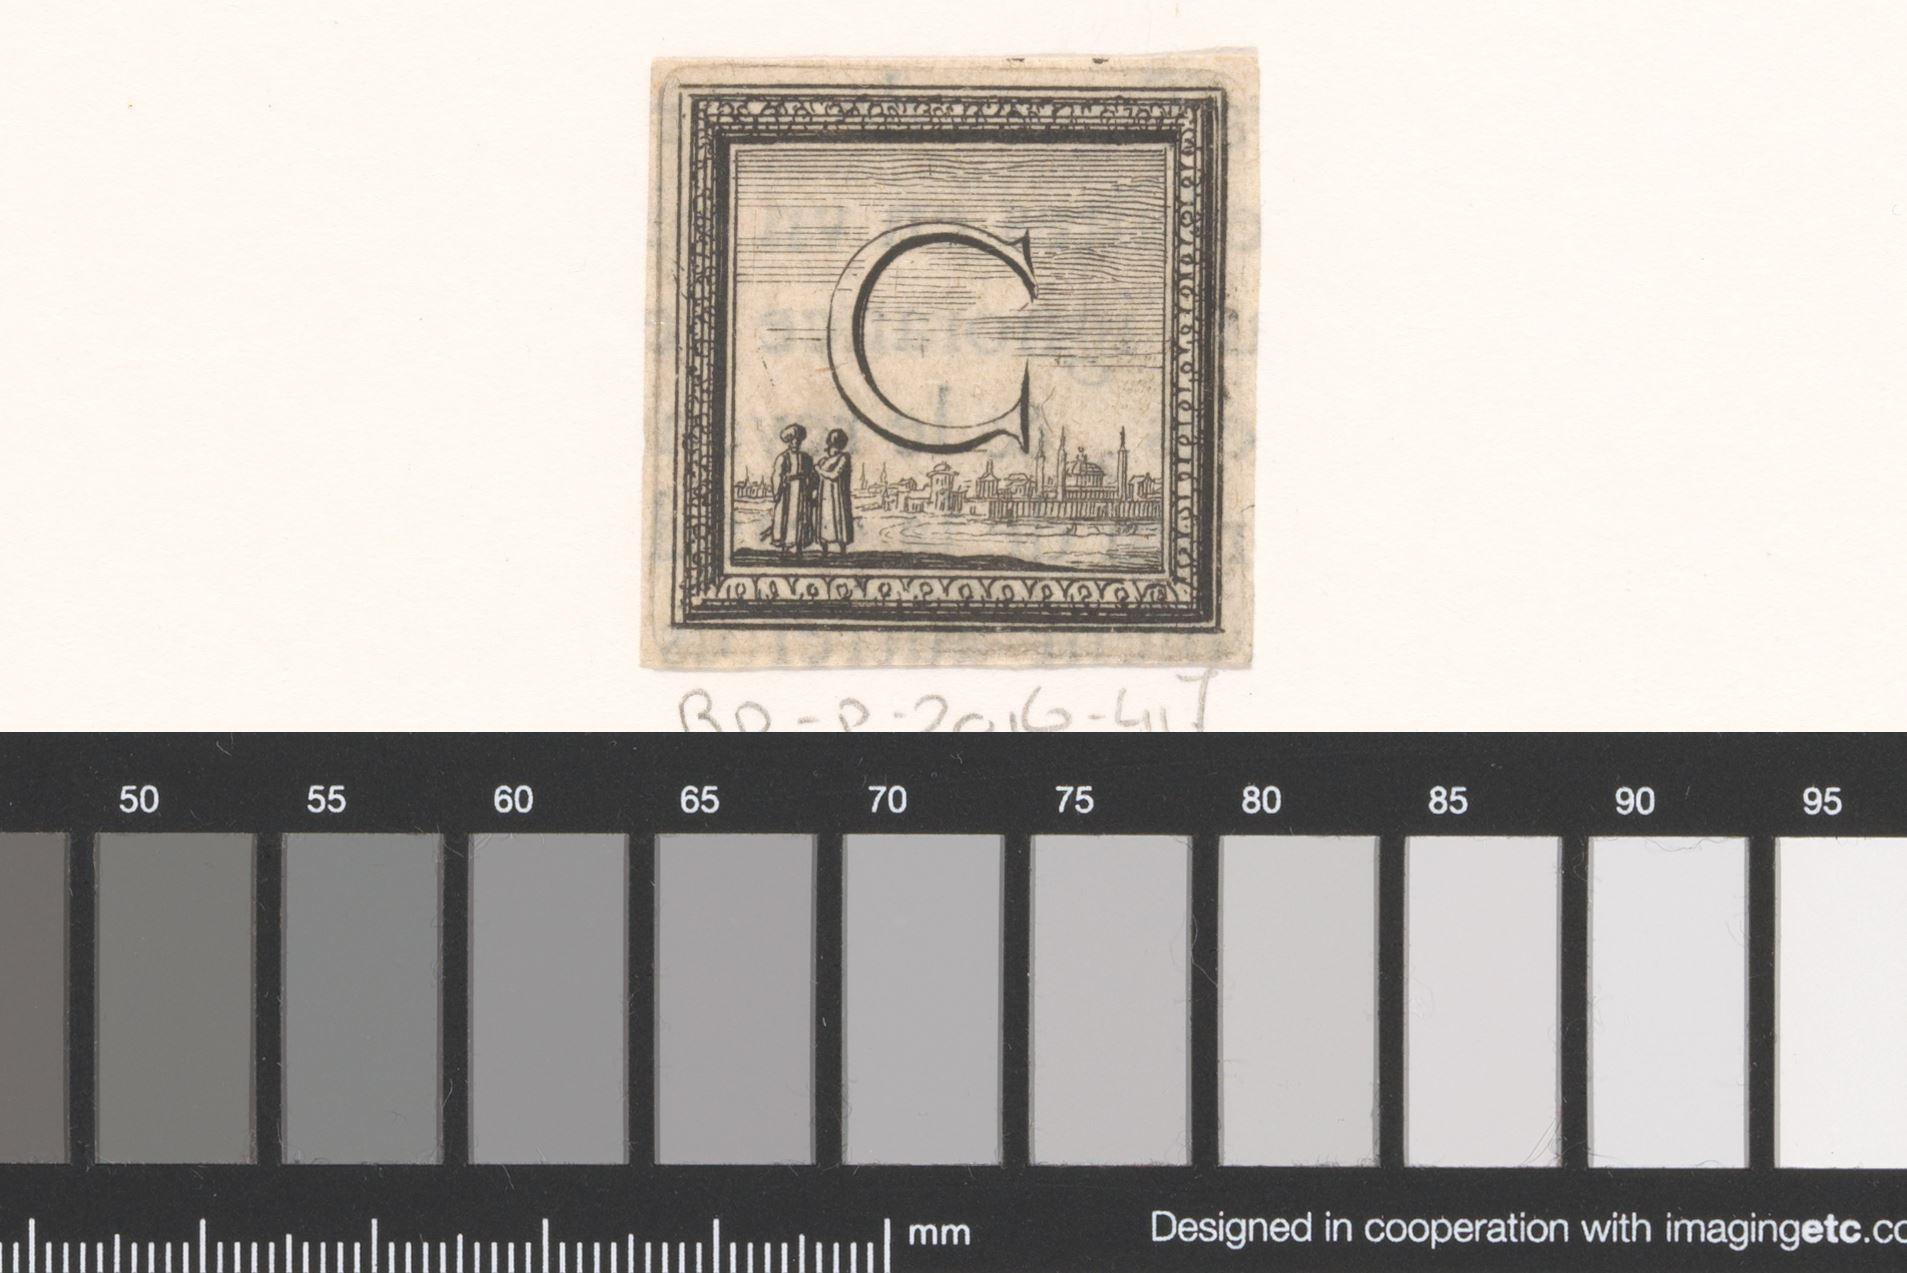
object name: book illustration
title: Letter C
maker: Anonymous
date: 1700-1799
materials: paper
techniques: etching, letterpress printing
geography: france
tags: fancy letters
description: Letter C tegen een achtergrond met twee mannen met tulband en uitzicht op de stad Istanbul / Constantinopel.